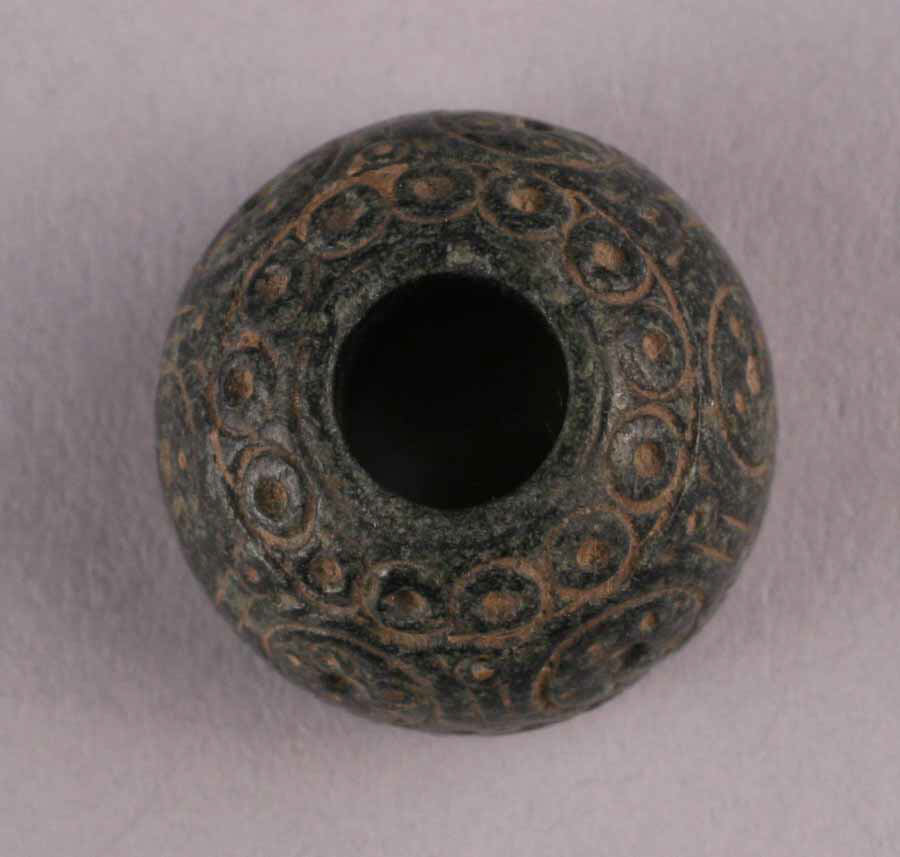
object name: button or bead or spindle whorl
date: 701-1000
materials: stone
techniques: incising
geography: iran